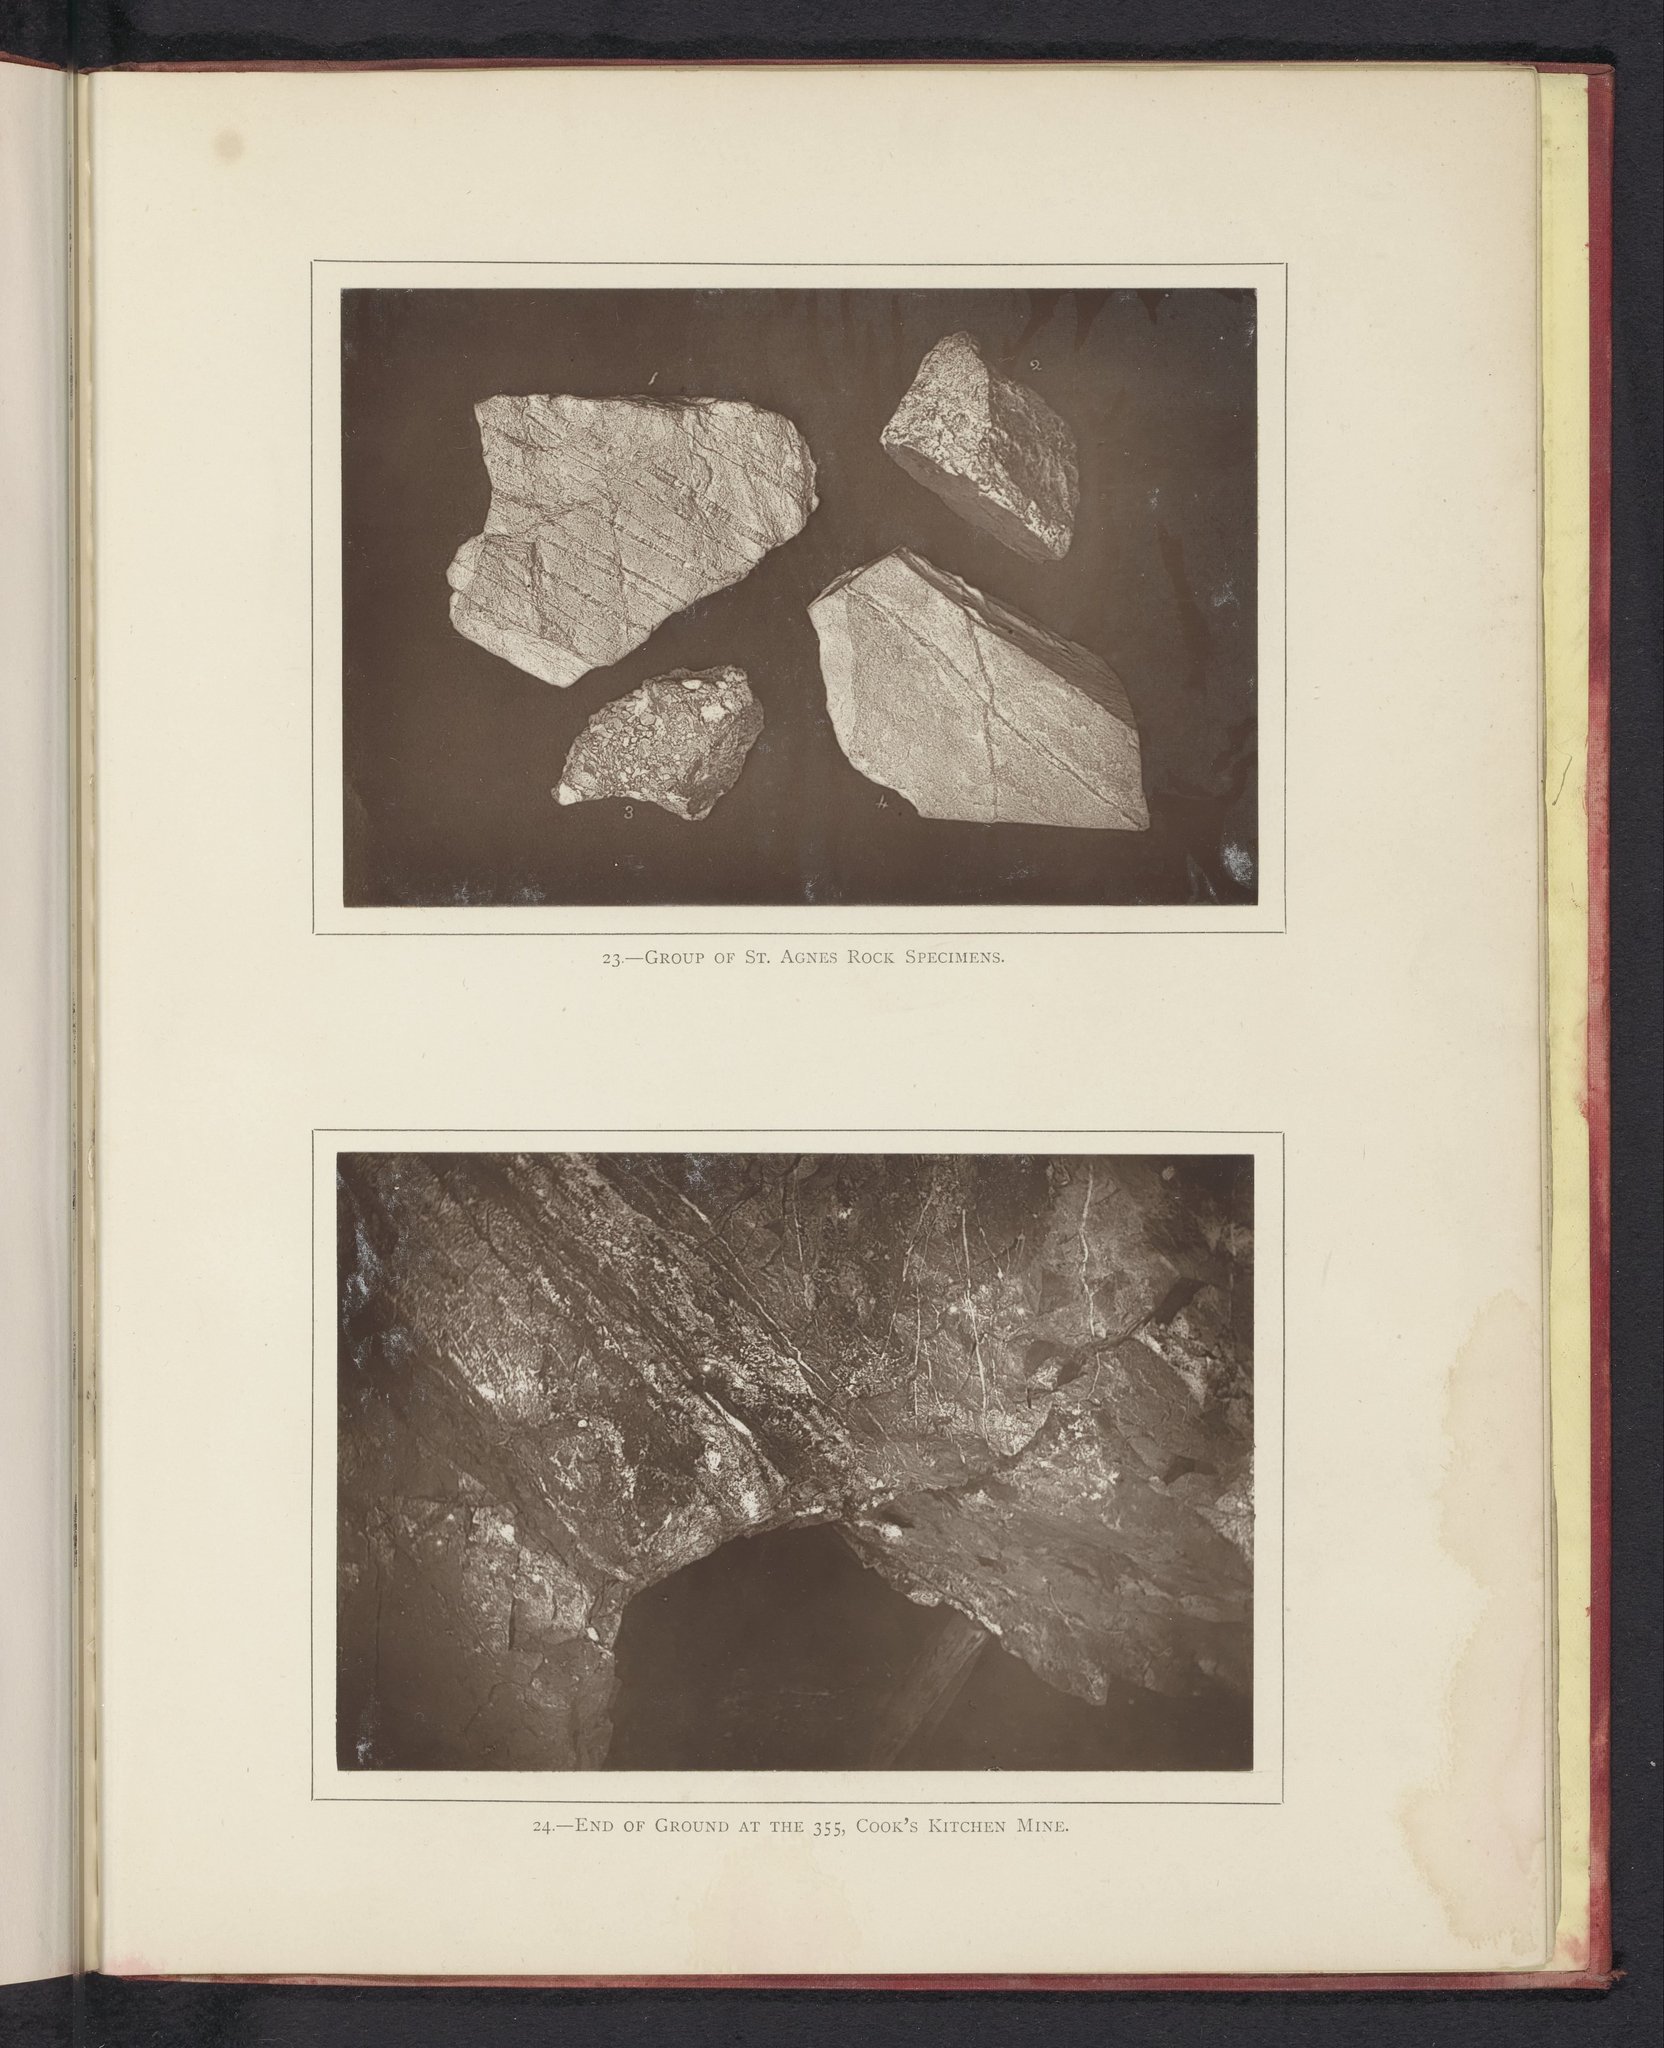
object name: page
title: Group of St. Agnes rock specimens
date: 1893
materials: paper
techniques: woodburytype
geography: cornwall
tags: shafts and galleries (of a mine), rocks, mine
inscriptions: number: ‘23.’, number: ‘24.’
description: Boven vier stenen, gedolven te St. Agnes, onder de rotswand in Cook's Kitchen Mine.